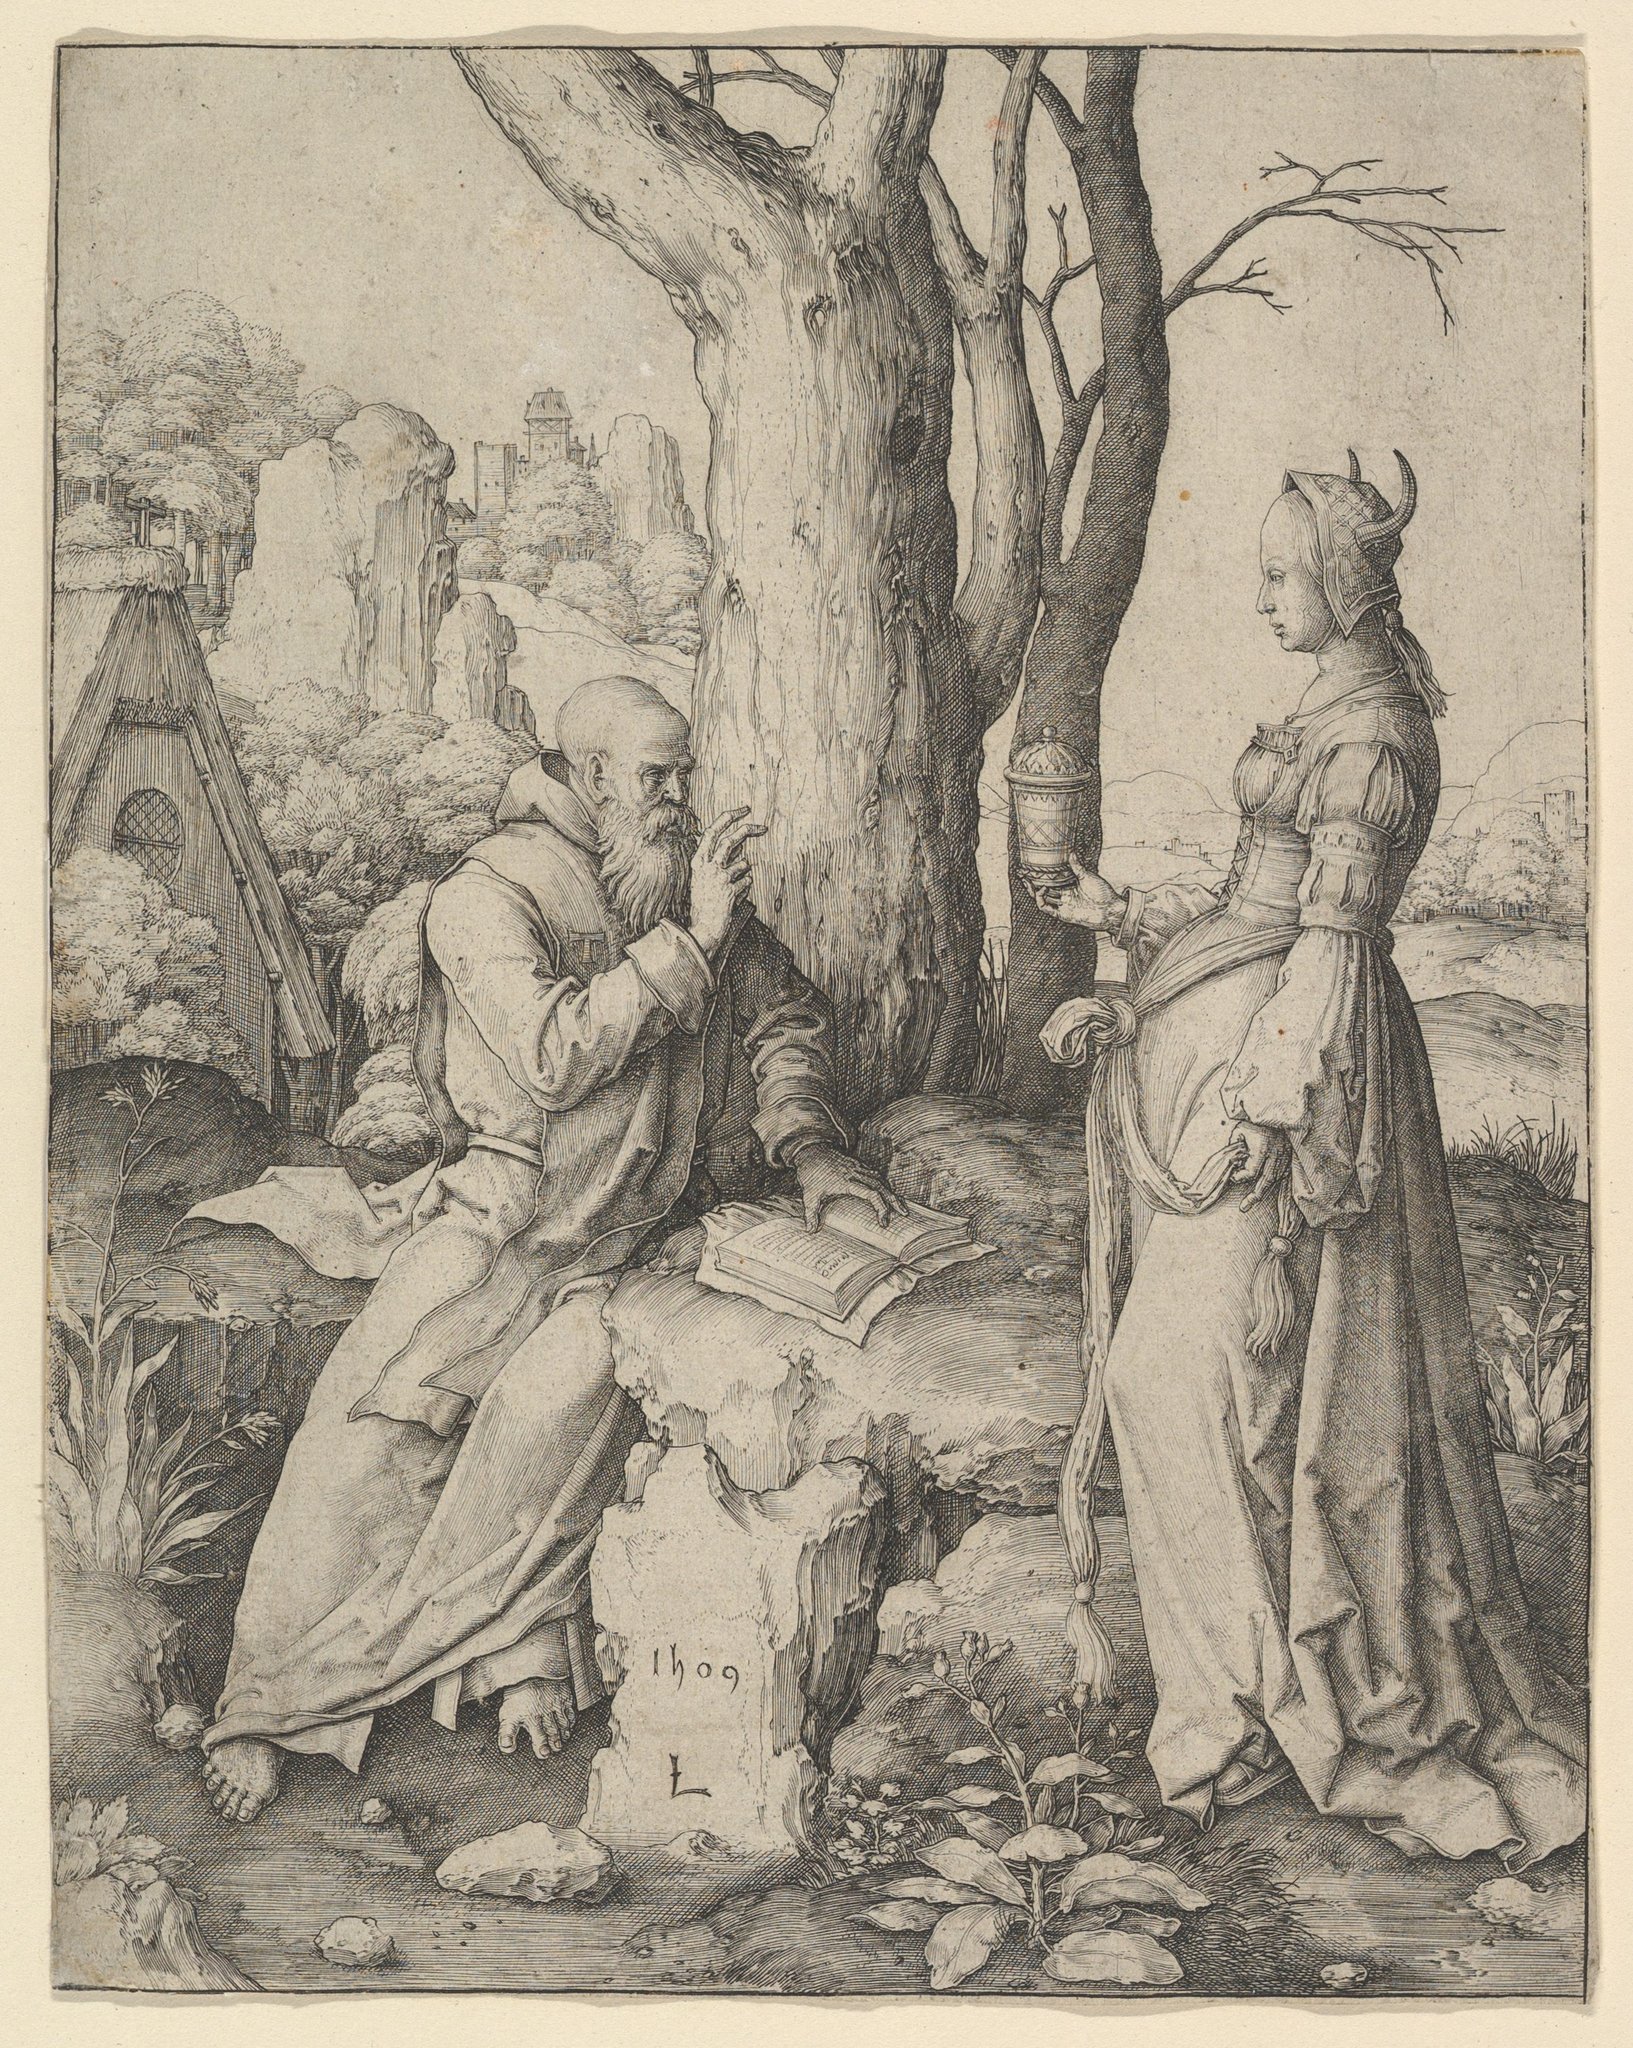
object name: print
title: The Temptation of St. Anthony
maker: lucas van leyden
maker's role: artist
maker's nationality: netherlandish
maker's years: 1494-1533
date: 1509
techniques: engraving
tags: books,men,women,trees,saint anthony